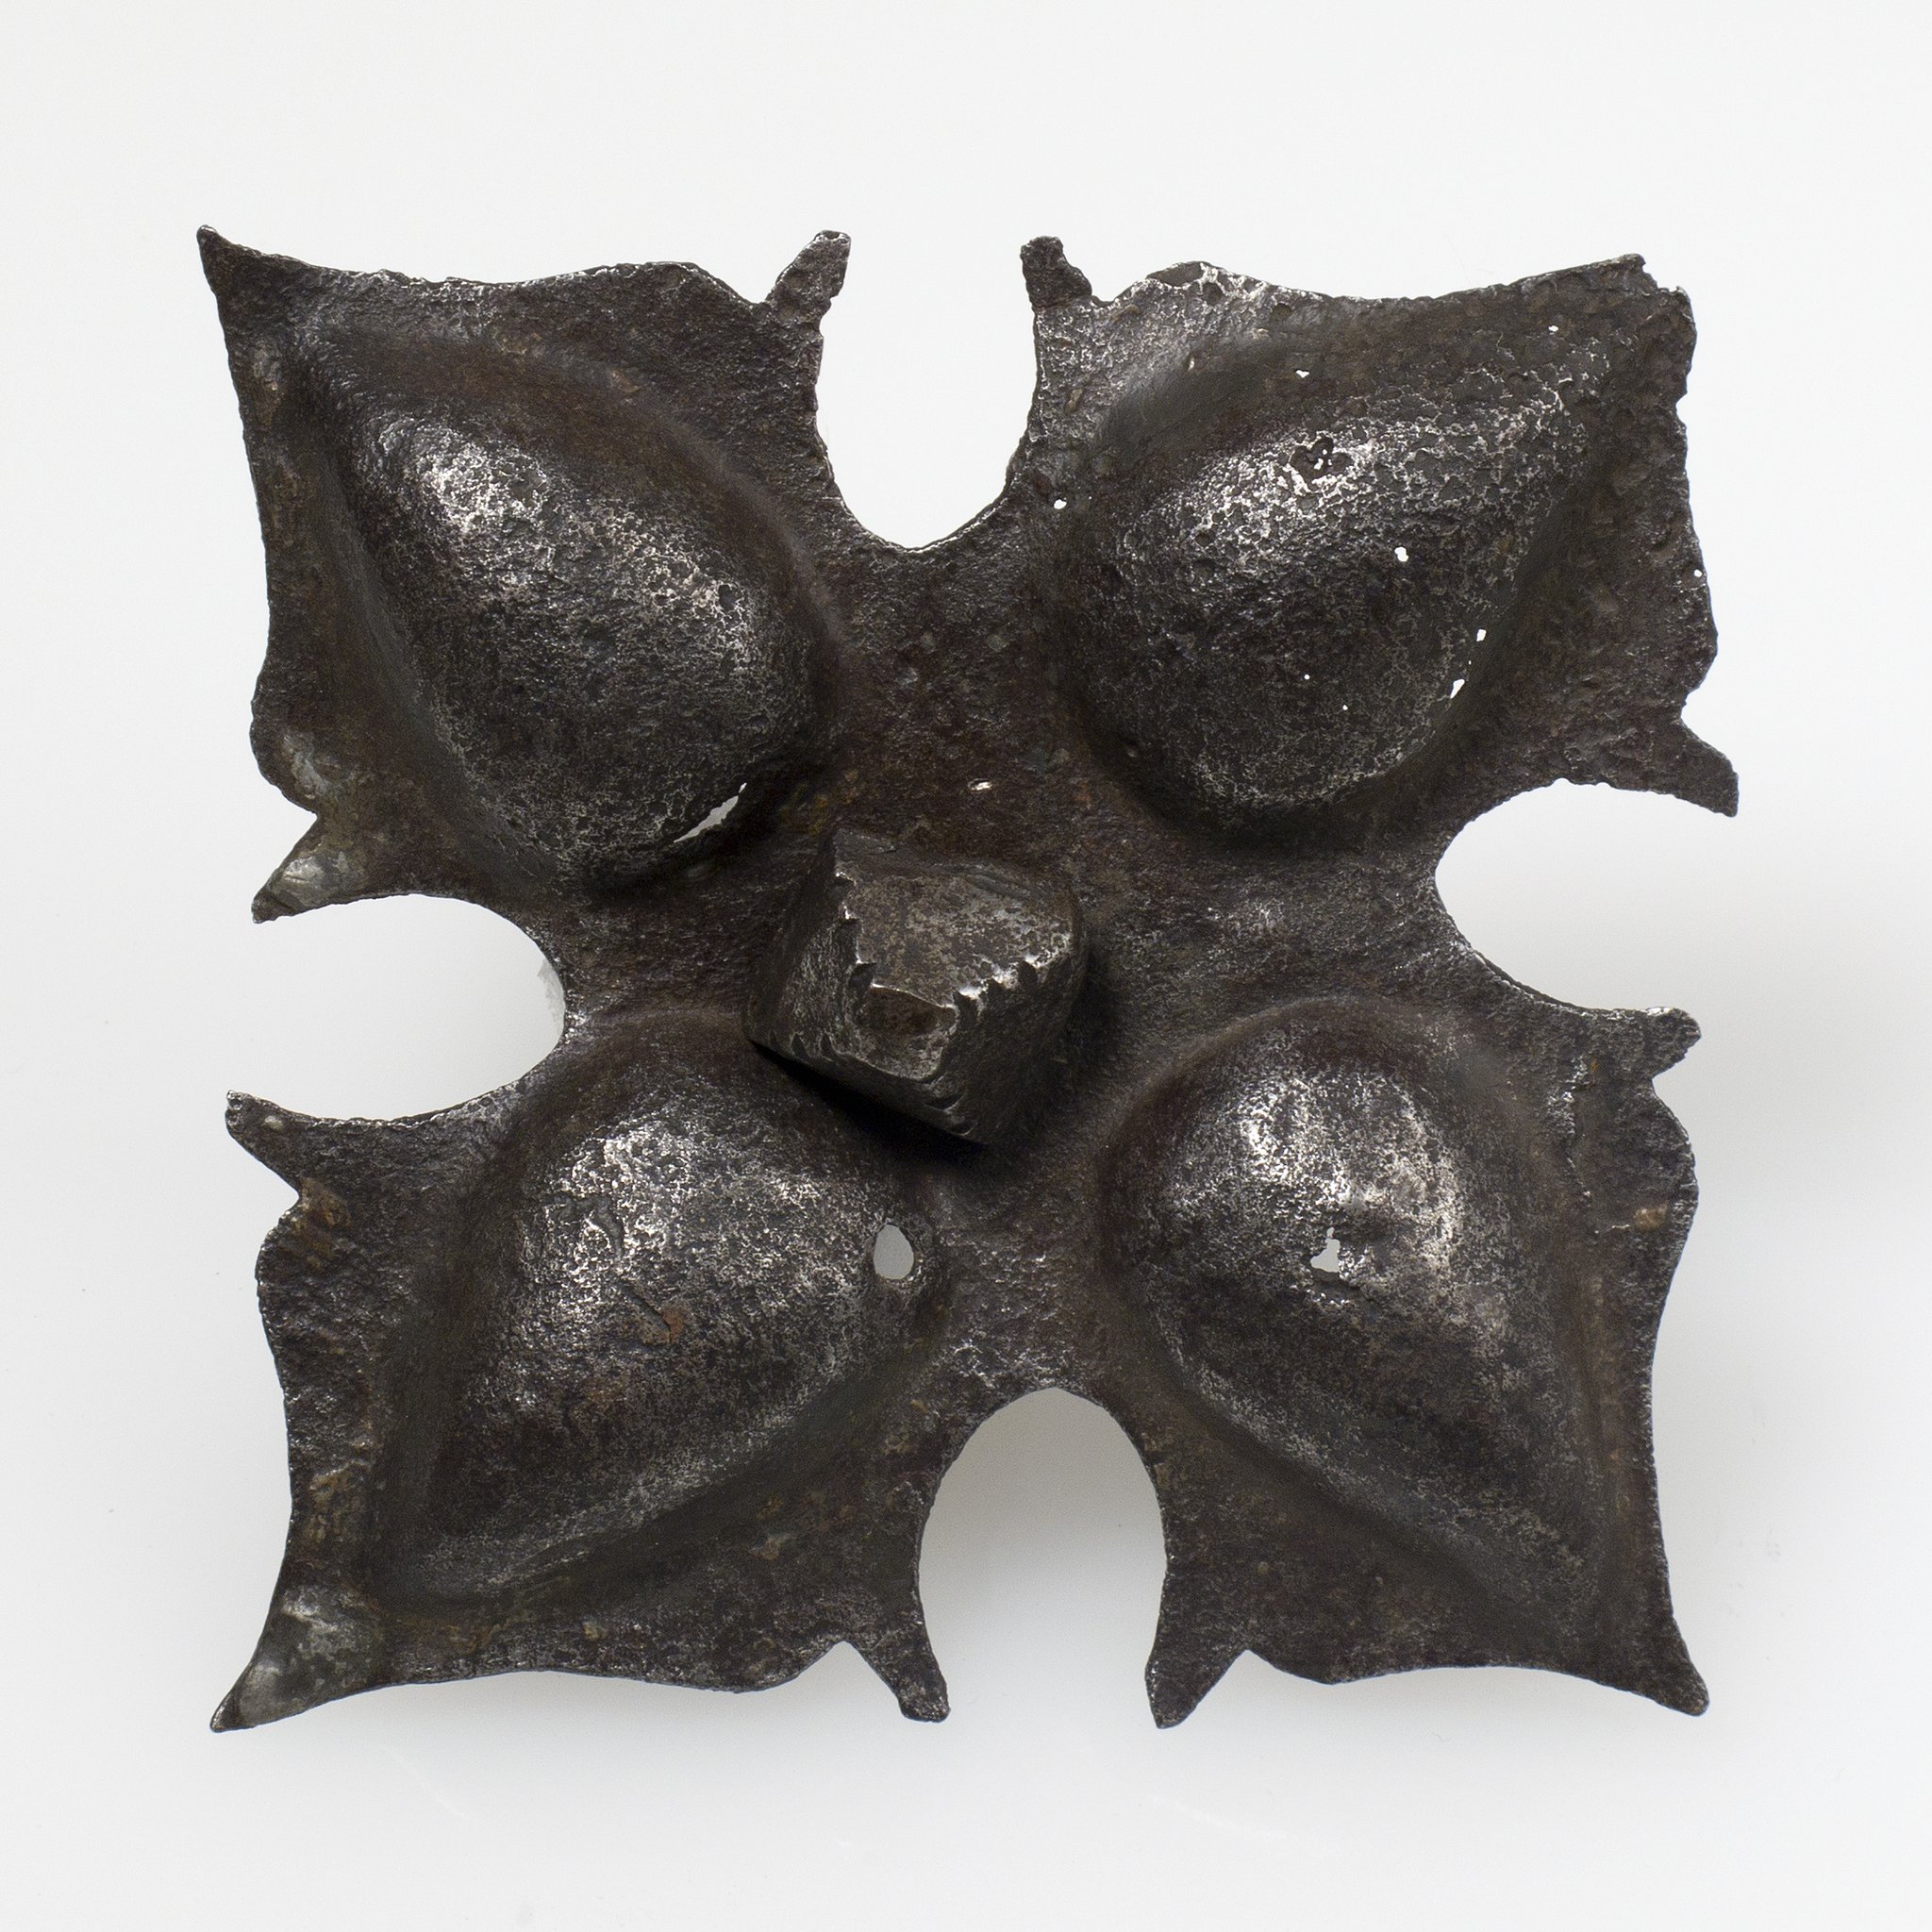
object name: plate and nail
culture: european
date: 1401-1600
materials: iron